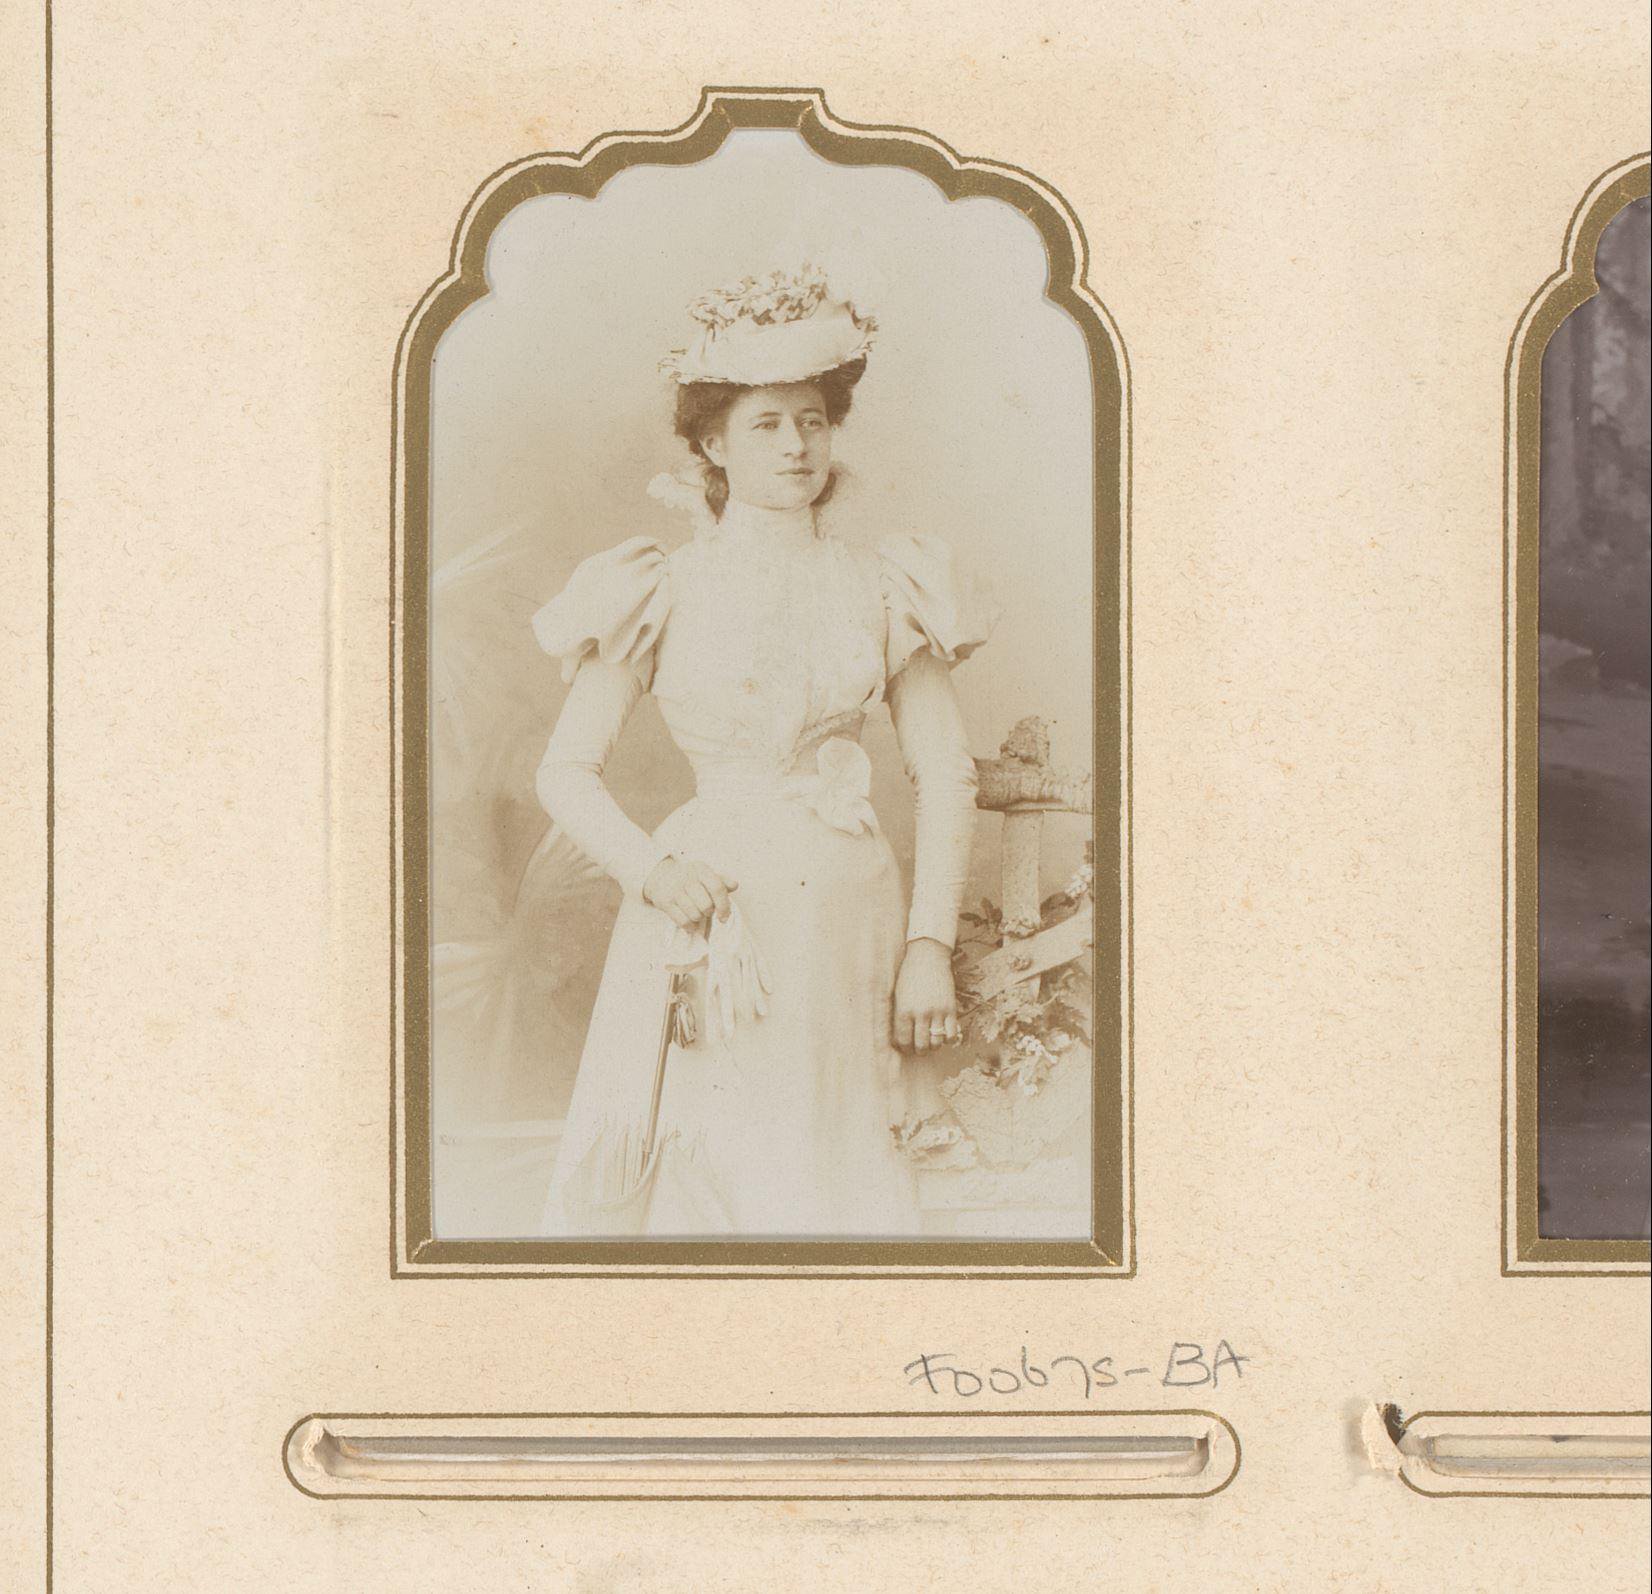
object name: photograph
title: Portret van een staande vrouw met handschoenen, paraplu en hoed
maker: henricus jacobus tollens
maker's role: painter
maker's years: 1864-1936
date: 1891-1905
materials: cardboard, photographic support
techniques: collodion silver print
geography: roermond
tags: historical persons - bb - woman, head-gear: hat, umbrella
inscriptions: inscription: ‘H.J. Tollens, C Hzn./ Roermond’